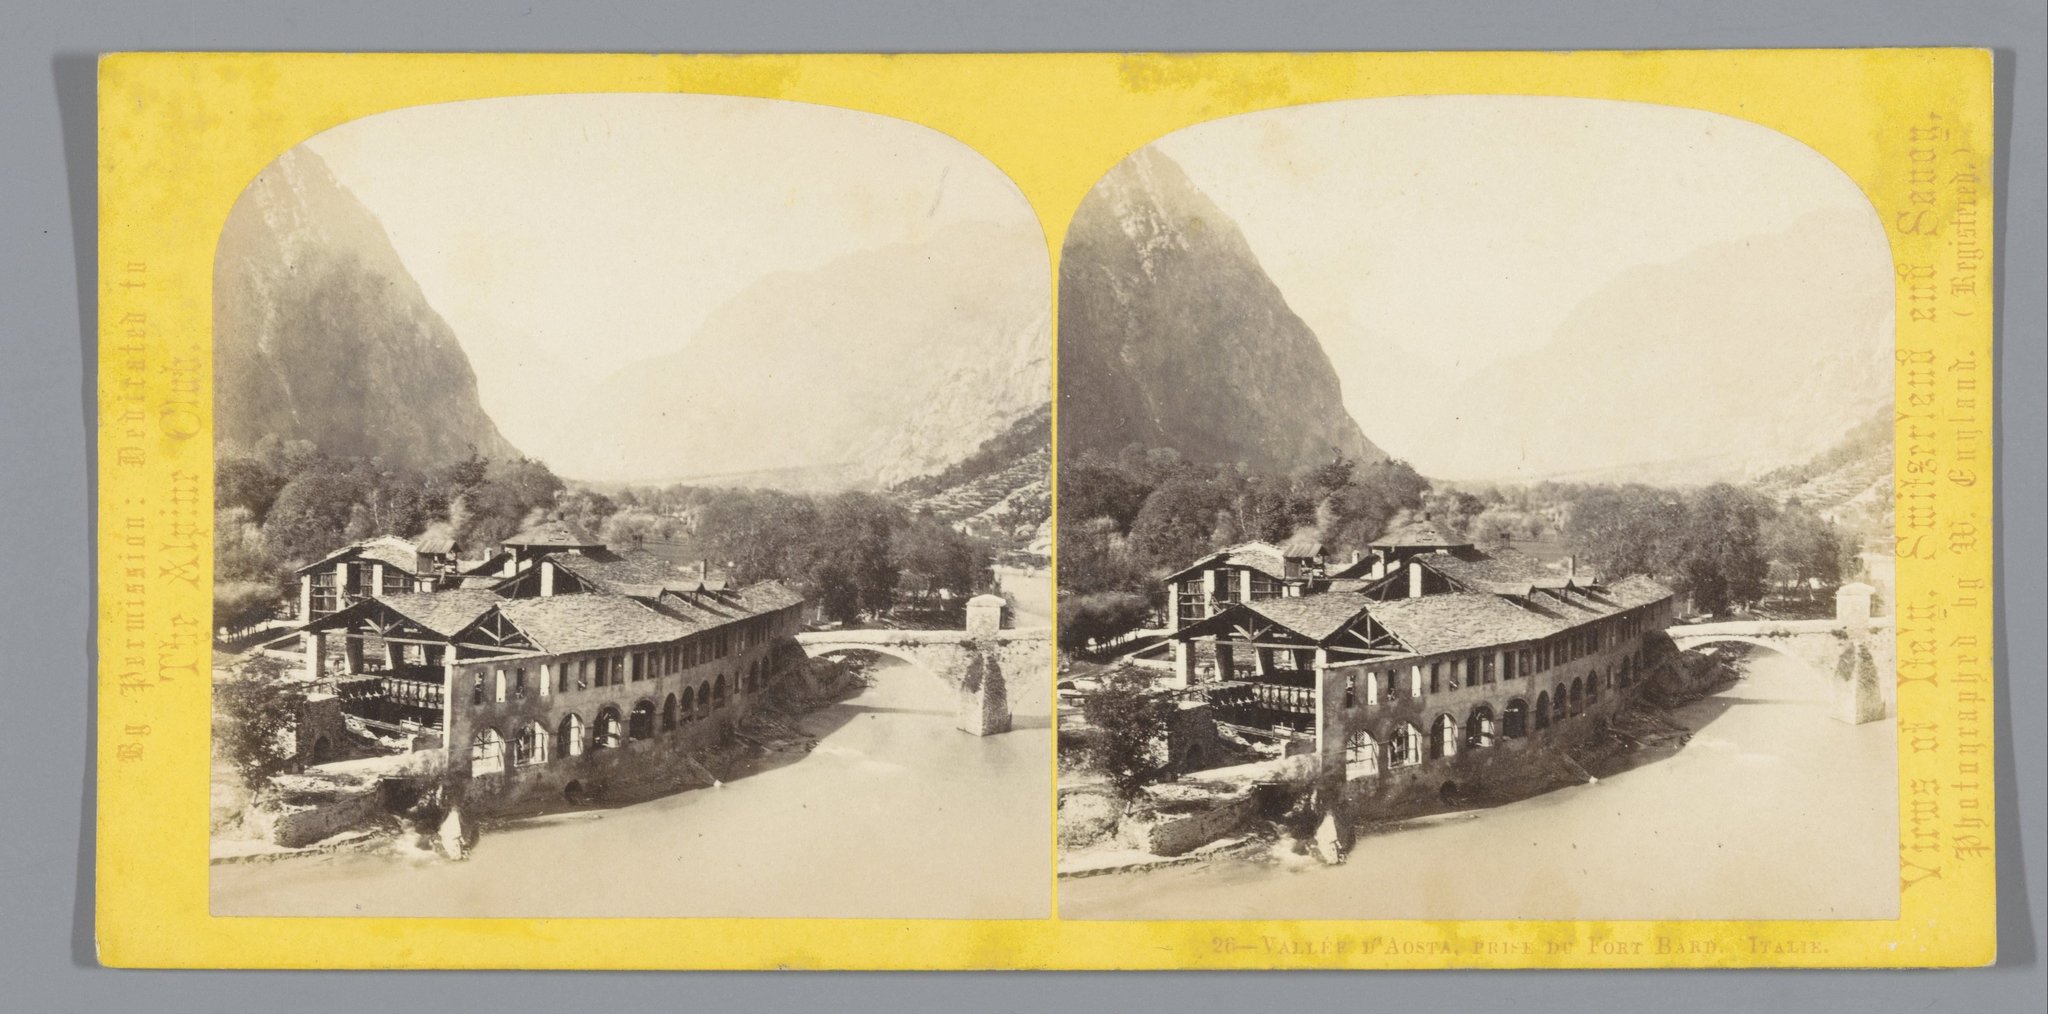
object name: stereograph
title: Gezicht op het Aostadal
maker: william england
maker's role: fotograaf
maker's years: 1816-1896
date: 1850-1880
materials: cardboard, photographic support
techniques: albumen print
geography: italy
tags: dale, valley, mountains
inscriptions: inscription: ‘N26. Vallée d'Aosta, prise du Fort Bard. Italie’, number: ‘26’, inscription: ‘By Permission: Dedicated to The Alpine Club’